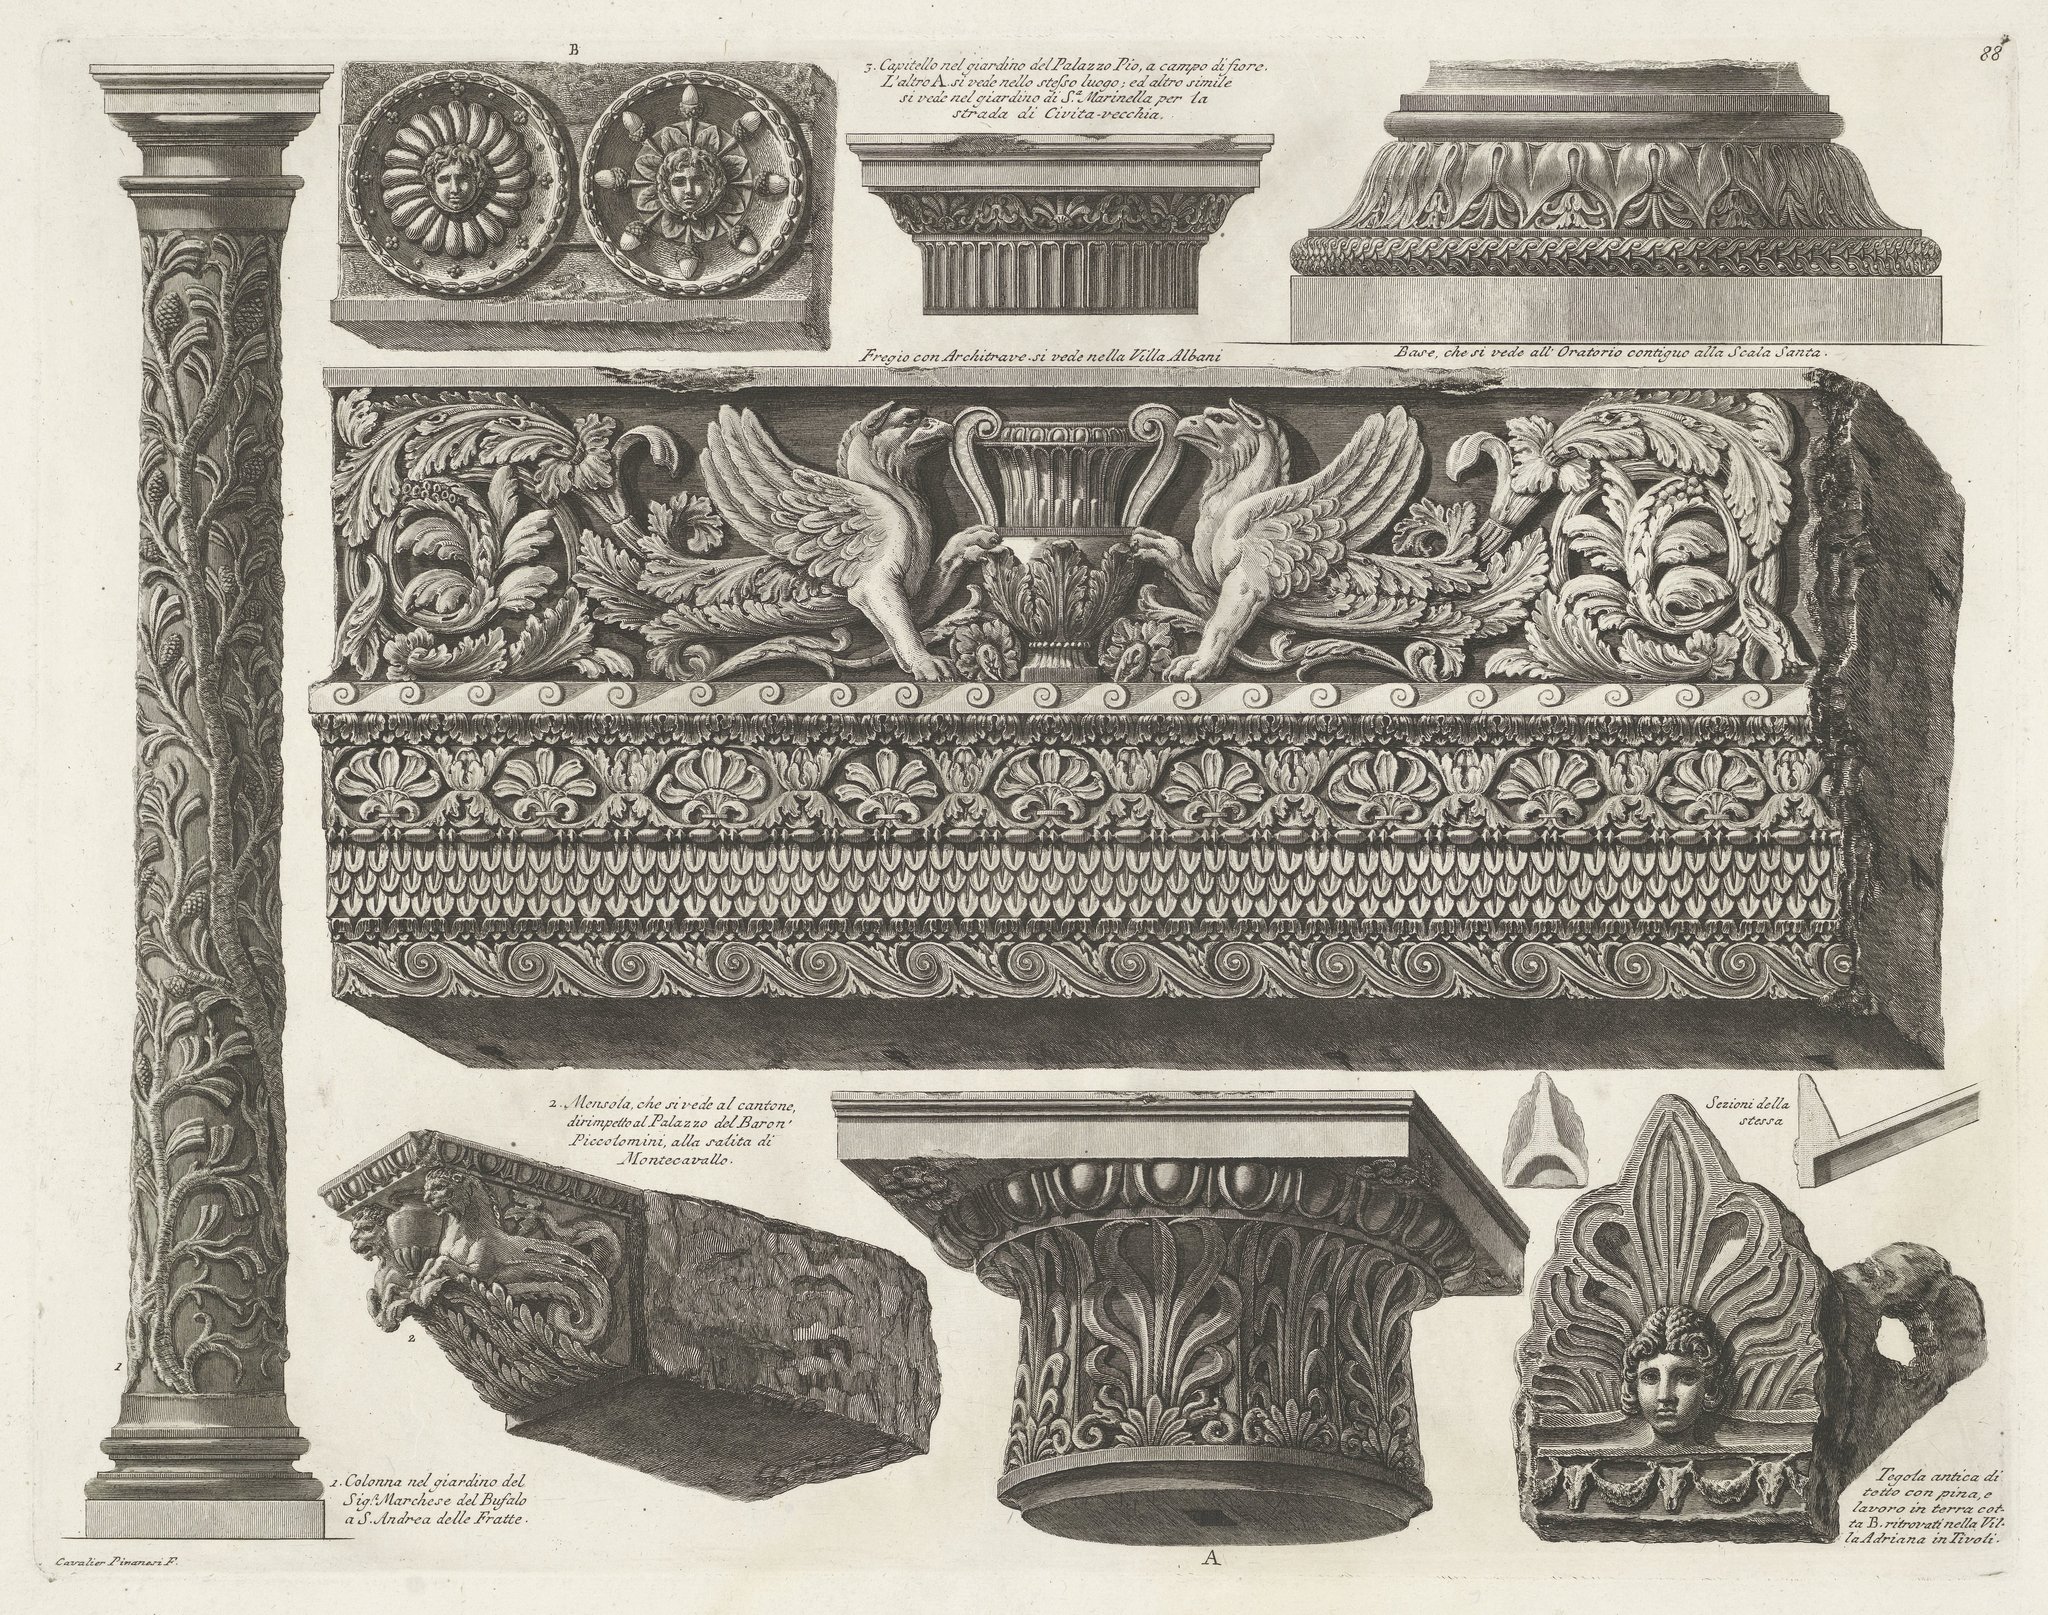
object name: print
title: Trofei di Ottaviano Augusto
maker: giovanni battista piranesi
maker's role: designer, draughtsman, print maker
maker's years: 1720-1778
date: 1753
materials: paper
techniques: etching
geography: rome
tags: column, pillar ~ architecture, piece of sculpture, reproduction of a piece of sculpture, capital (~ column, pillar), base (~ column, pillar), rome, tivoli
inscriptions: collector's mark: Lugt 2228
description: Acht verschillende architectuurfragmenten uit Rome en Tivoli, zoals een zuil, een fries met griffioenen, kapitelen en een zuilbasis. Genummerd rechtsboven: 88.